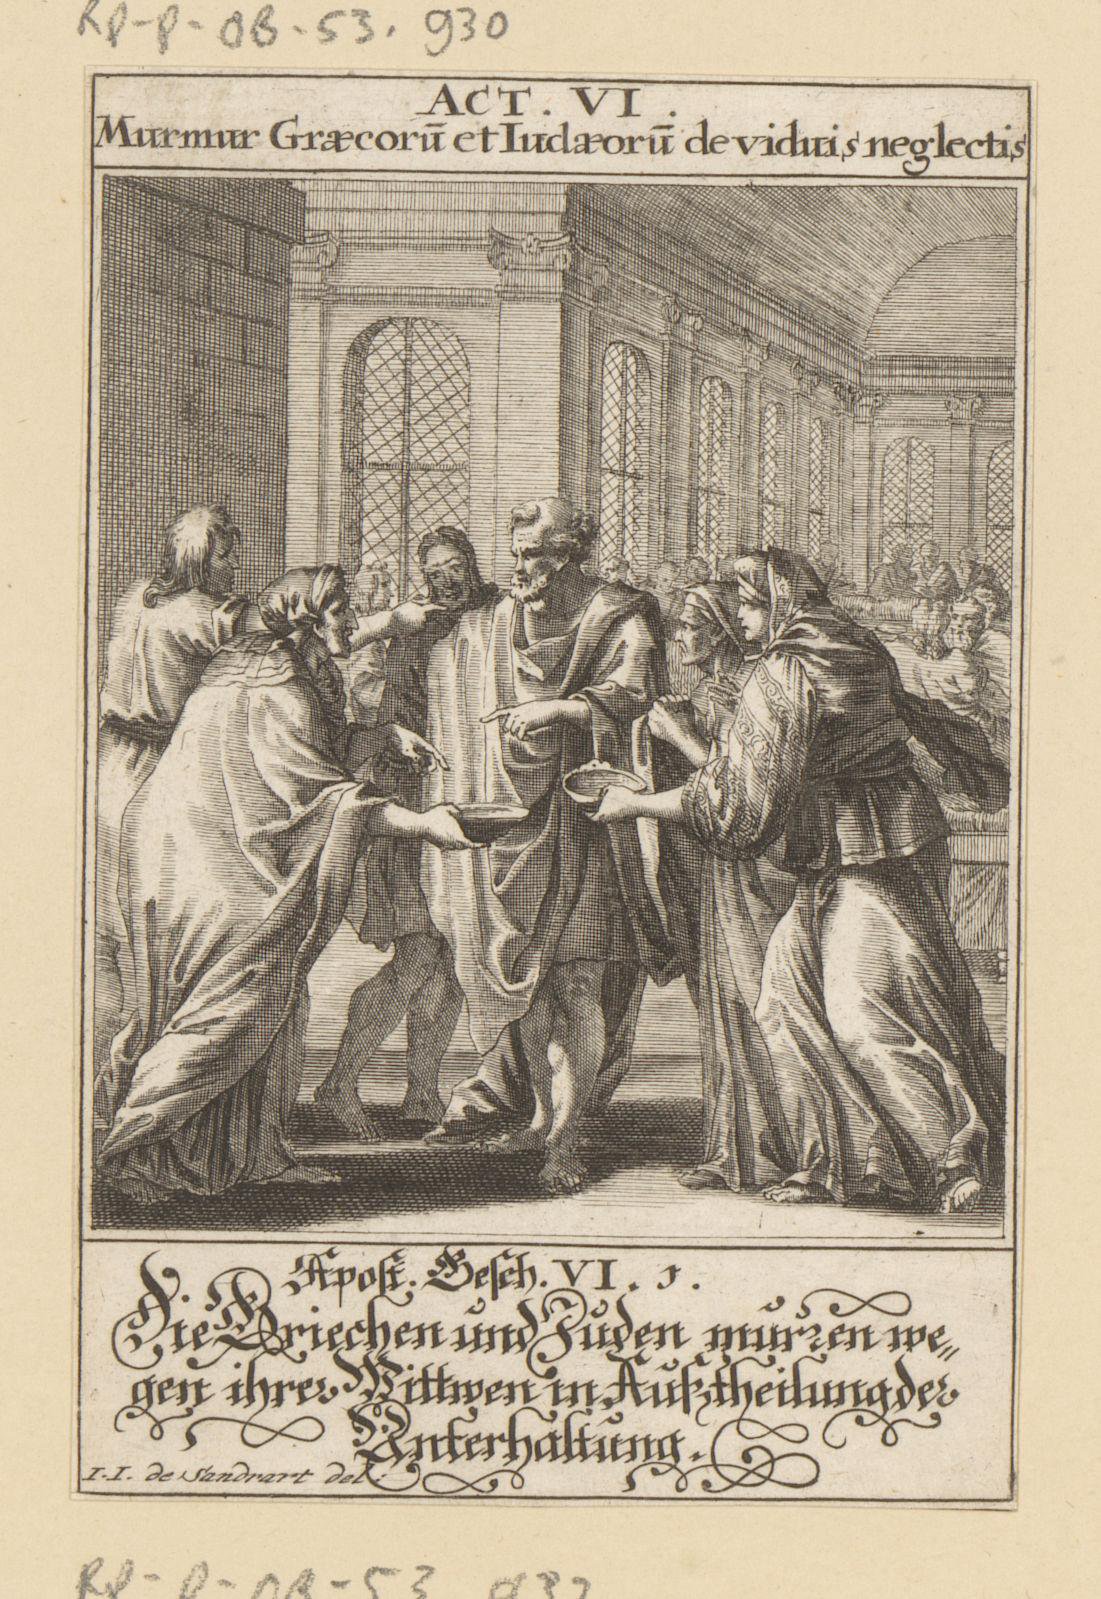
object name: print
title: Gemor van de Grieken en Hebreeën vanwege verwaarlozing van de weduwen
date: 1697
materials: paper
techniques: etching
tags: christ and apostles distribute bread and fish among the multitude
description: Prent ook gebruikt in: Biblia ectypa : Bildnussen auss Heiliger Schrifft. Regensburg: Chr. Wiegel, 1697.